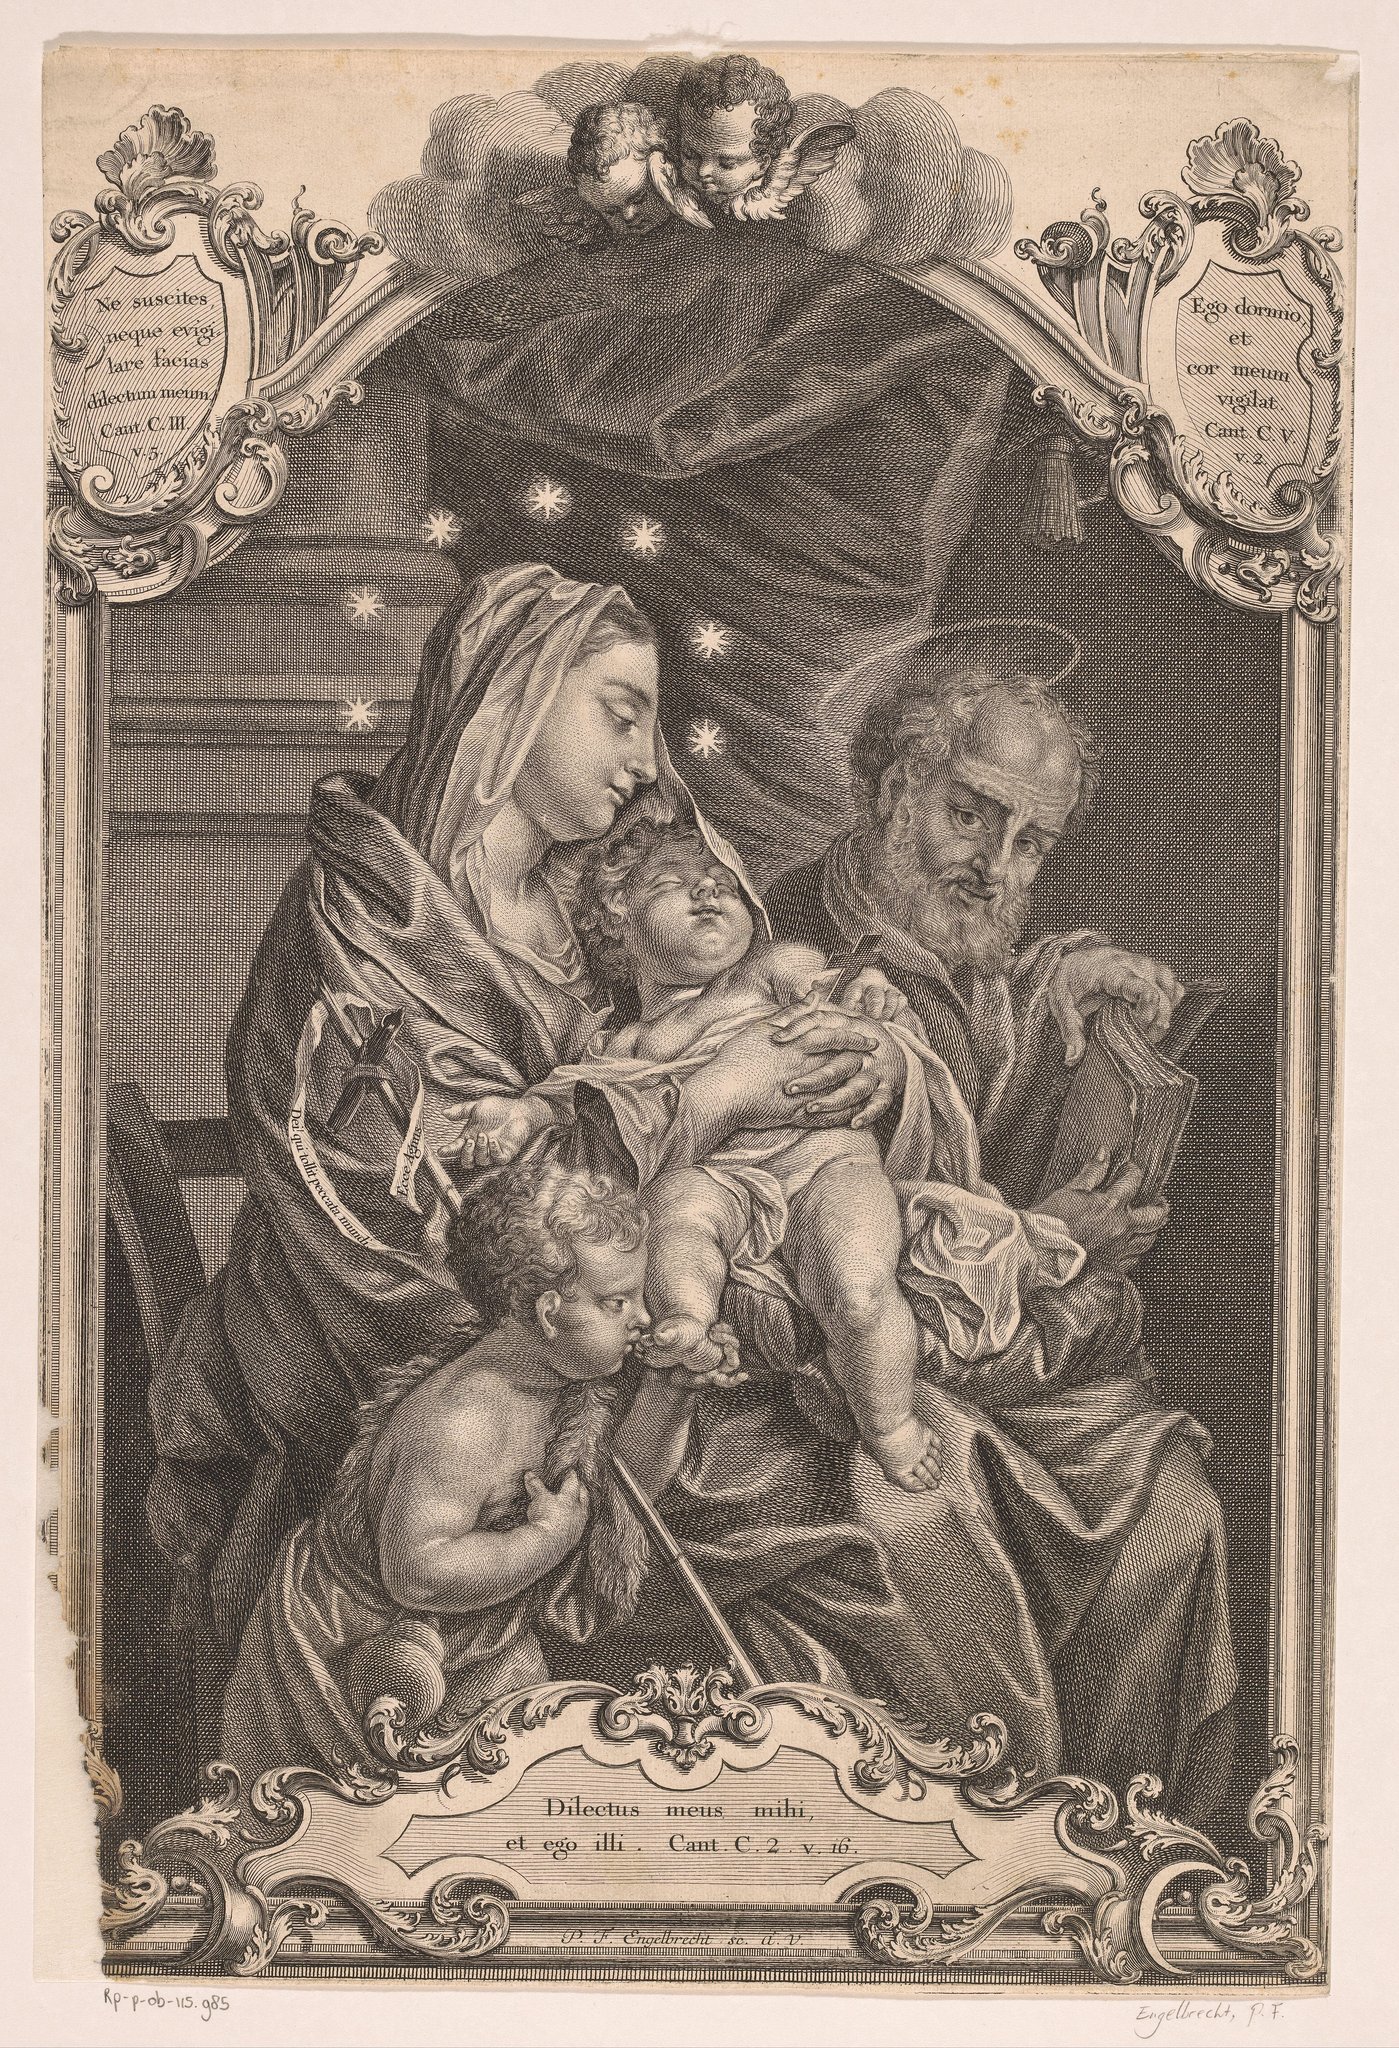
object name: print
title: Maria met kind, naast hen Jozef en Johannes de Doper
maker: paul friedrich engelbrecht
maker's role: print maker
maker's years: 1719-1776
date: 1729-1776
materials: paper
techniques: engraving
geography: augsburg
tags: john the baptist; possible attributes: book, reed cross, baptismal cup, honeycomb, lamb, staff - early life of male saint, cherubs, i.e. children's heads with wings, rocaille ornament, (feigned) picture curtain, the foster-father of christ, joseph of nazareth, husband of mary; possible attributes: flowering rod or wand, lily, carpenter's tools, specific types of madonna with others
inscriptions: collector's mark: Lugt 2228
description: Rondom drie cartouches met delen uit cantates van Claudio Monteverdi.